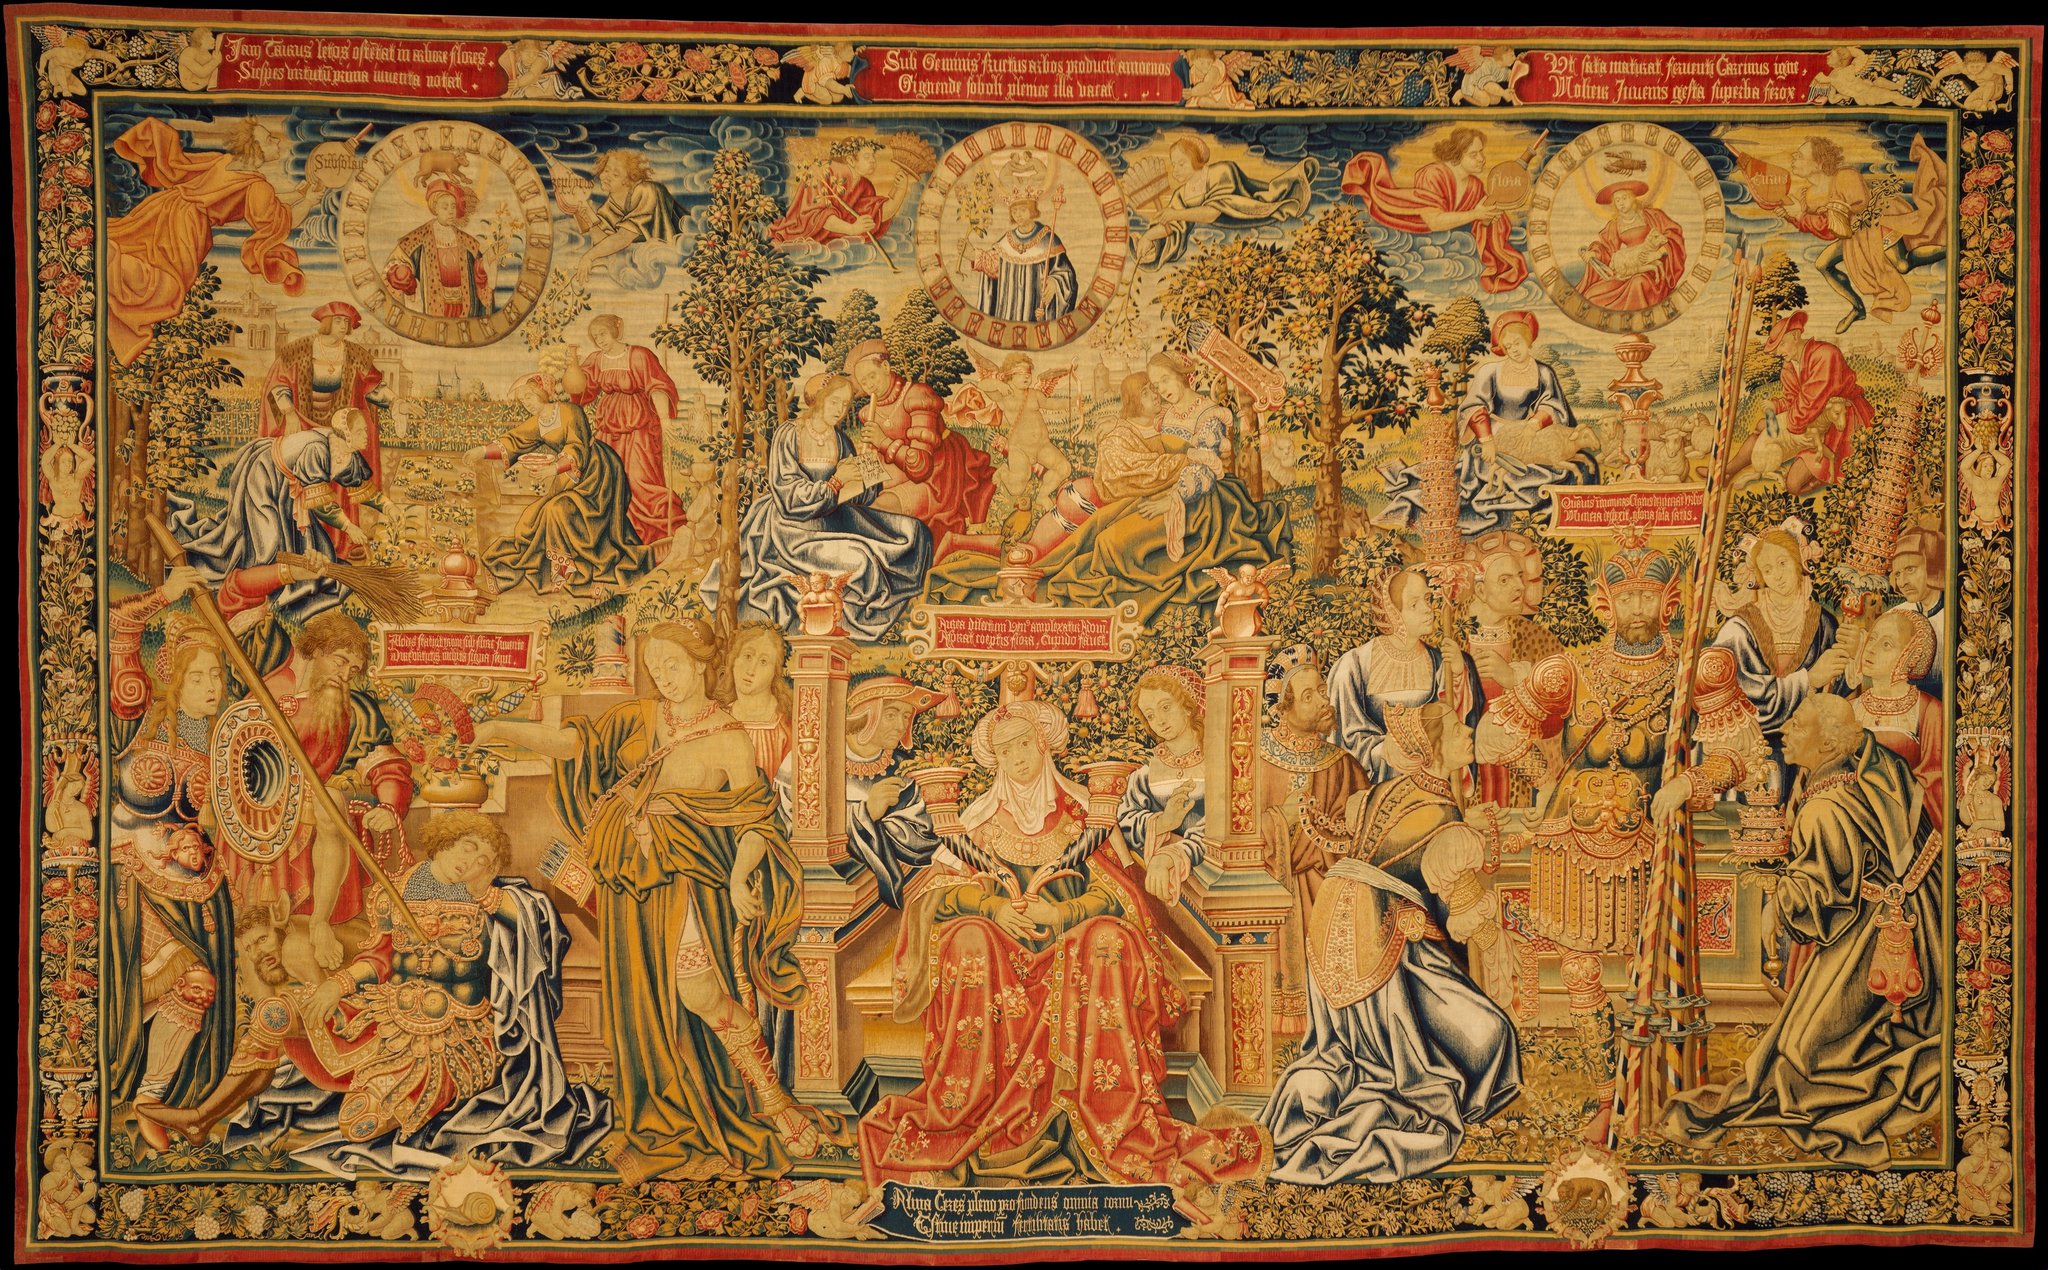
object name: tapestry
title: The Twelve Ages of a Man: The Second Three Ages (18-36), or Summer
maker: bernard van orley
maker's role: designer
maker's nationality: netherlandish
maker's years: 1492-1542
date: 1515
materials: silk, wool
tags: musical instruments,fruit,cupid,hercules,putti,ceres,minerva,venus,flowers,summer,zodiac